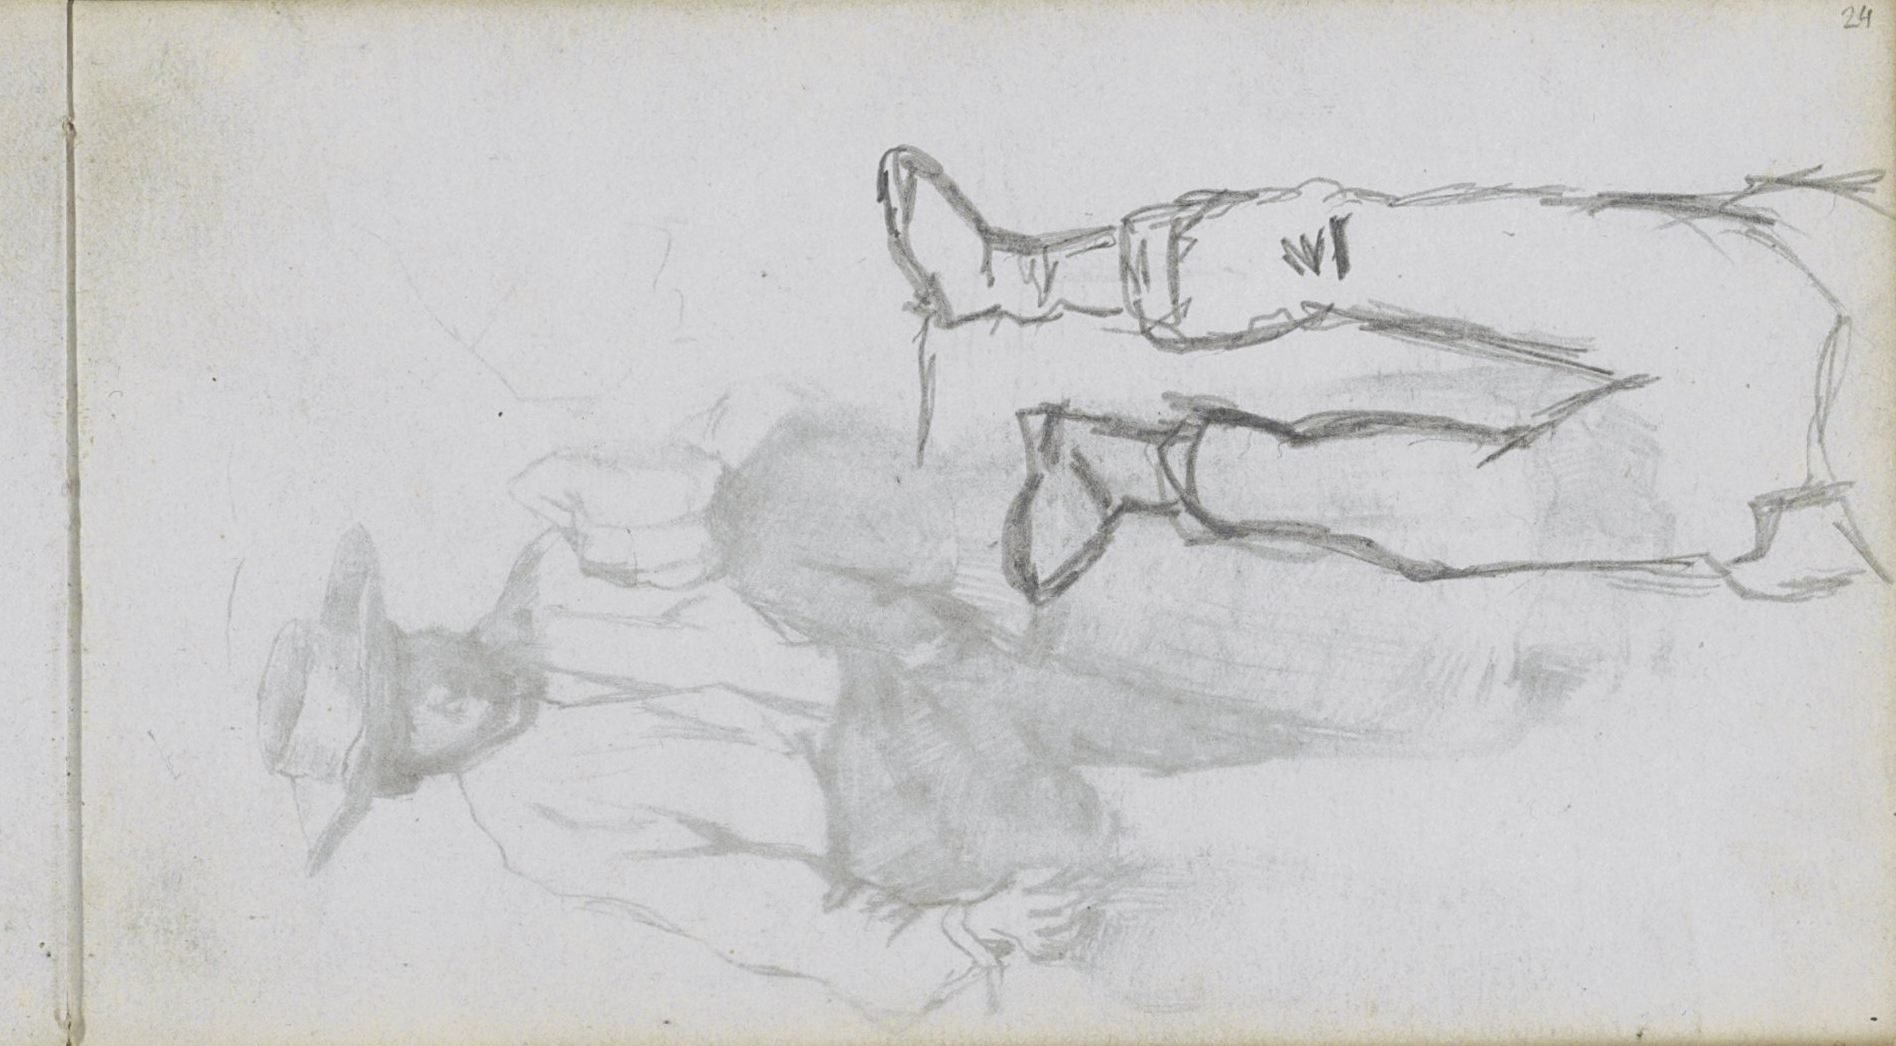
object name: sketchbook leaf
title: Onderlichaam van een man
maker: johan hendrik weissenbruch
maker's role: draughtsman, painter, print maker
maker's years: 1824-1903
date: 1834-1903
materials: paper, pencil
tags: legs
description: Blad 24 recto uit een schetsboek met 39 bladen.